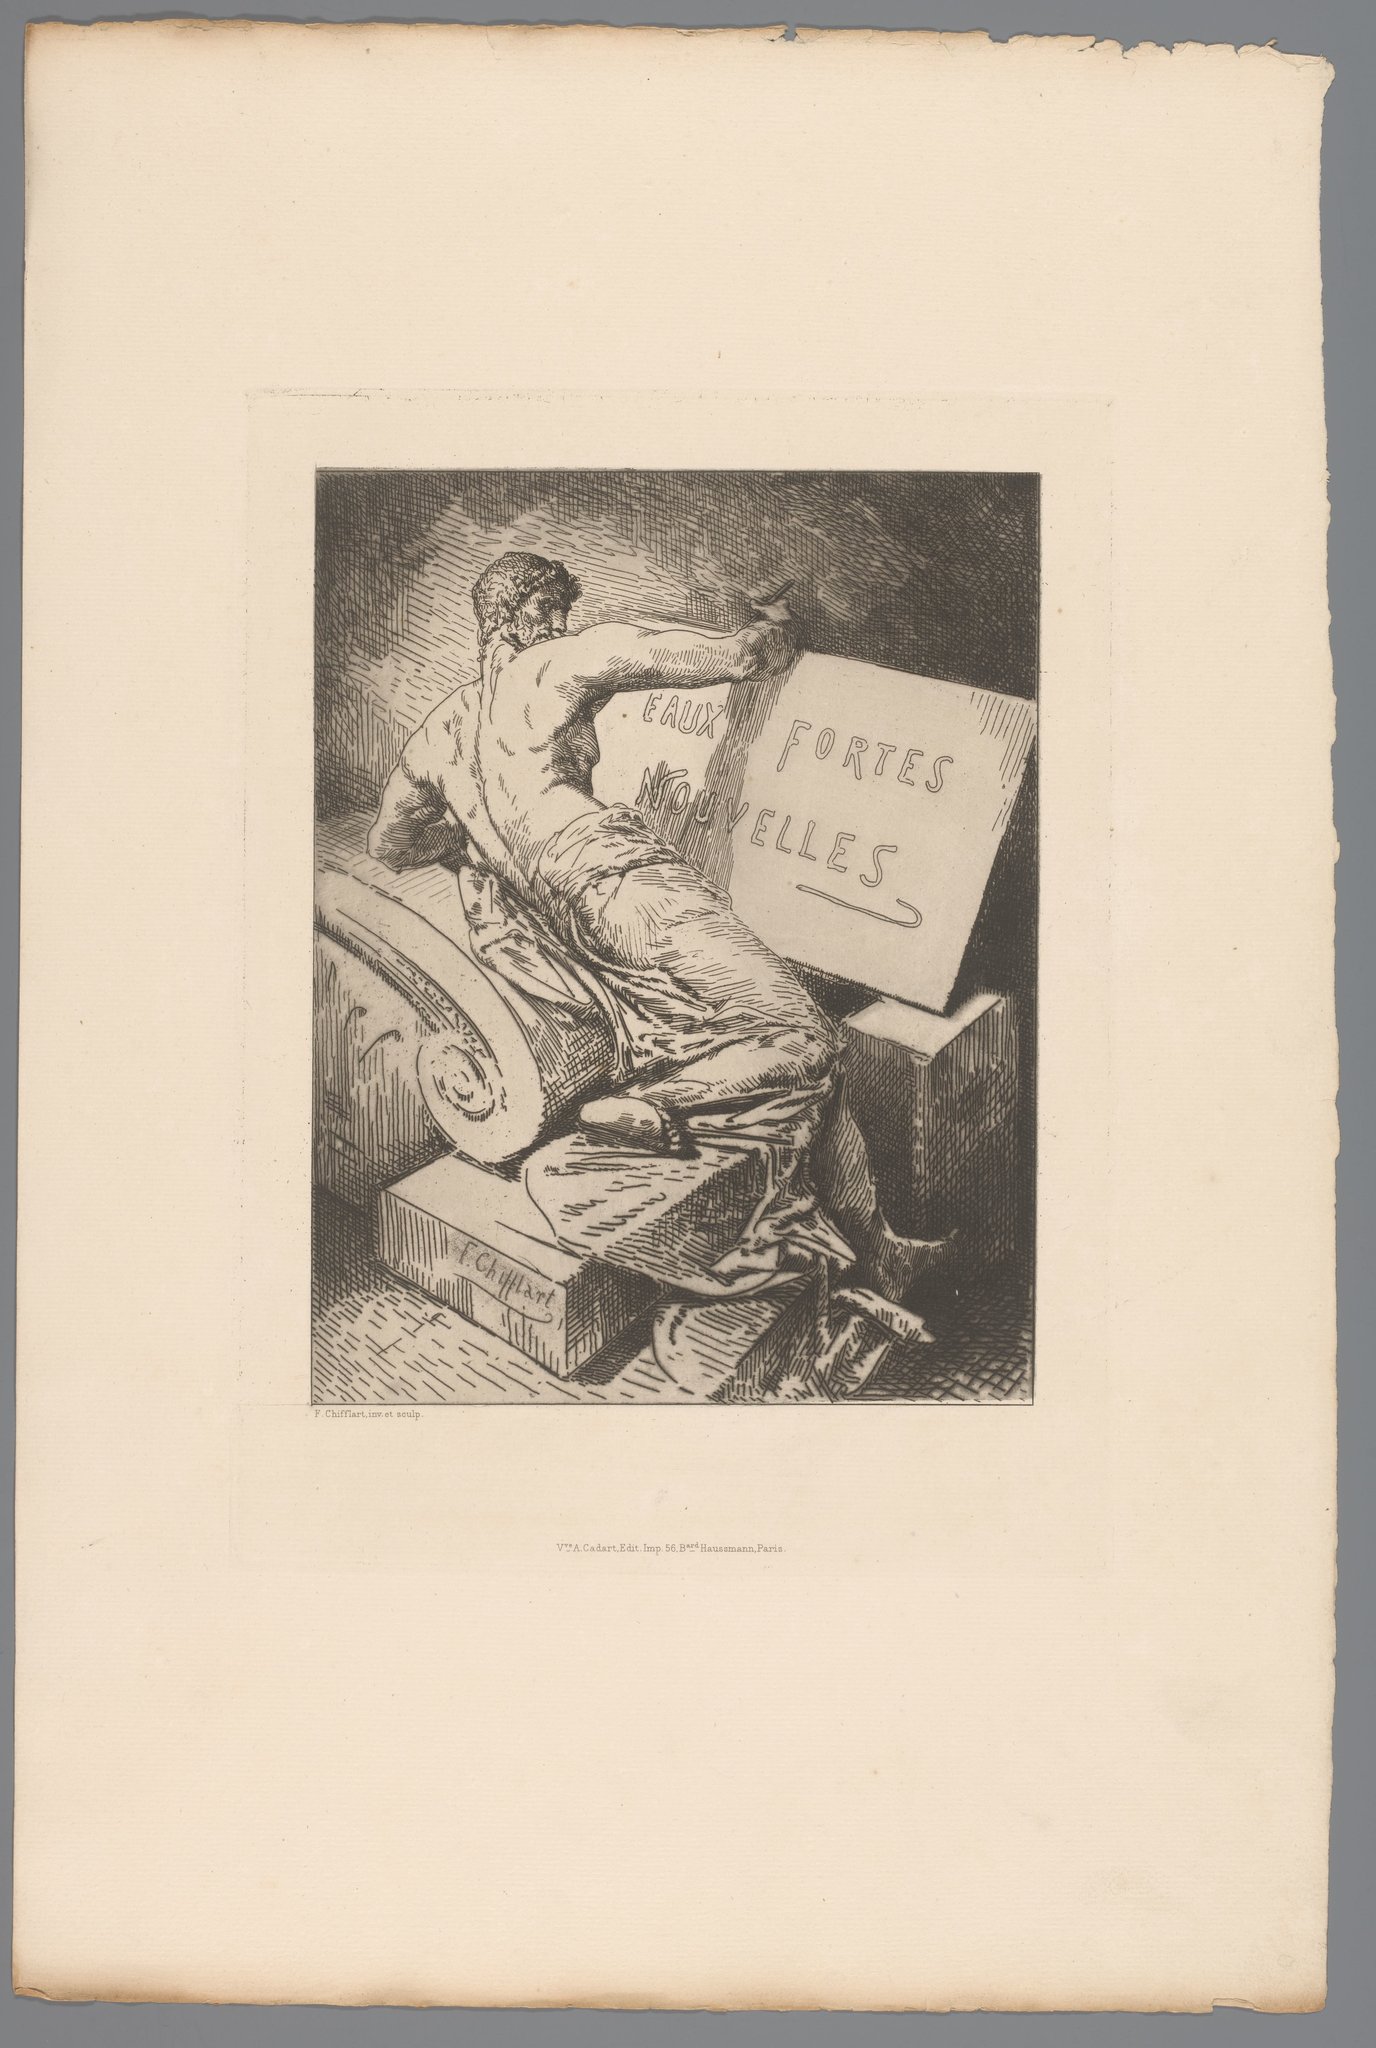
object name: print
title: Eaux fortes nouvelles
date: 1877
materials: paper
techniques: drypoint, etching, intaglio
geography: paris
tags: symbolic representations, allegories and emblems ~ the graphic arts, print, e.g.: engraving, etching, lithograph, adult man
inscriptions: collector's mark: ‘AFE v S’, collector's mark: Lugt 2228, collector's mark: Lugt 2760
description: Man in een klassiek gewaad als allegorie op het drukken van prenten.